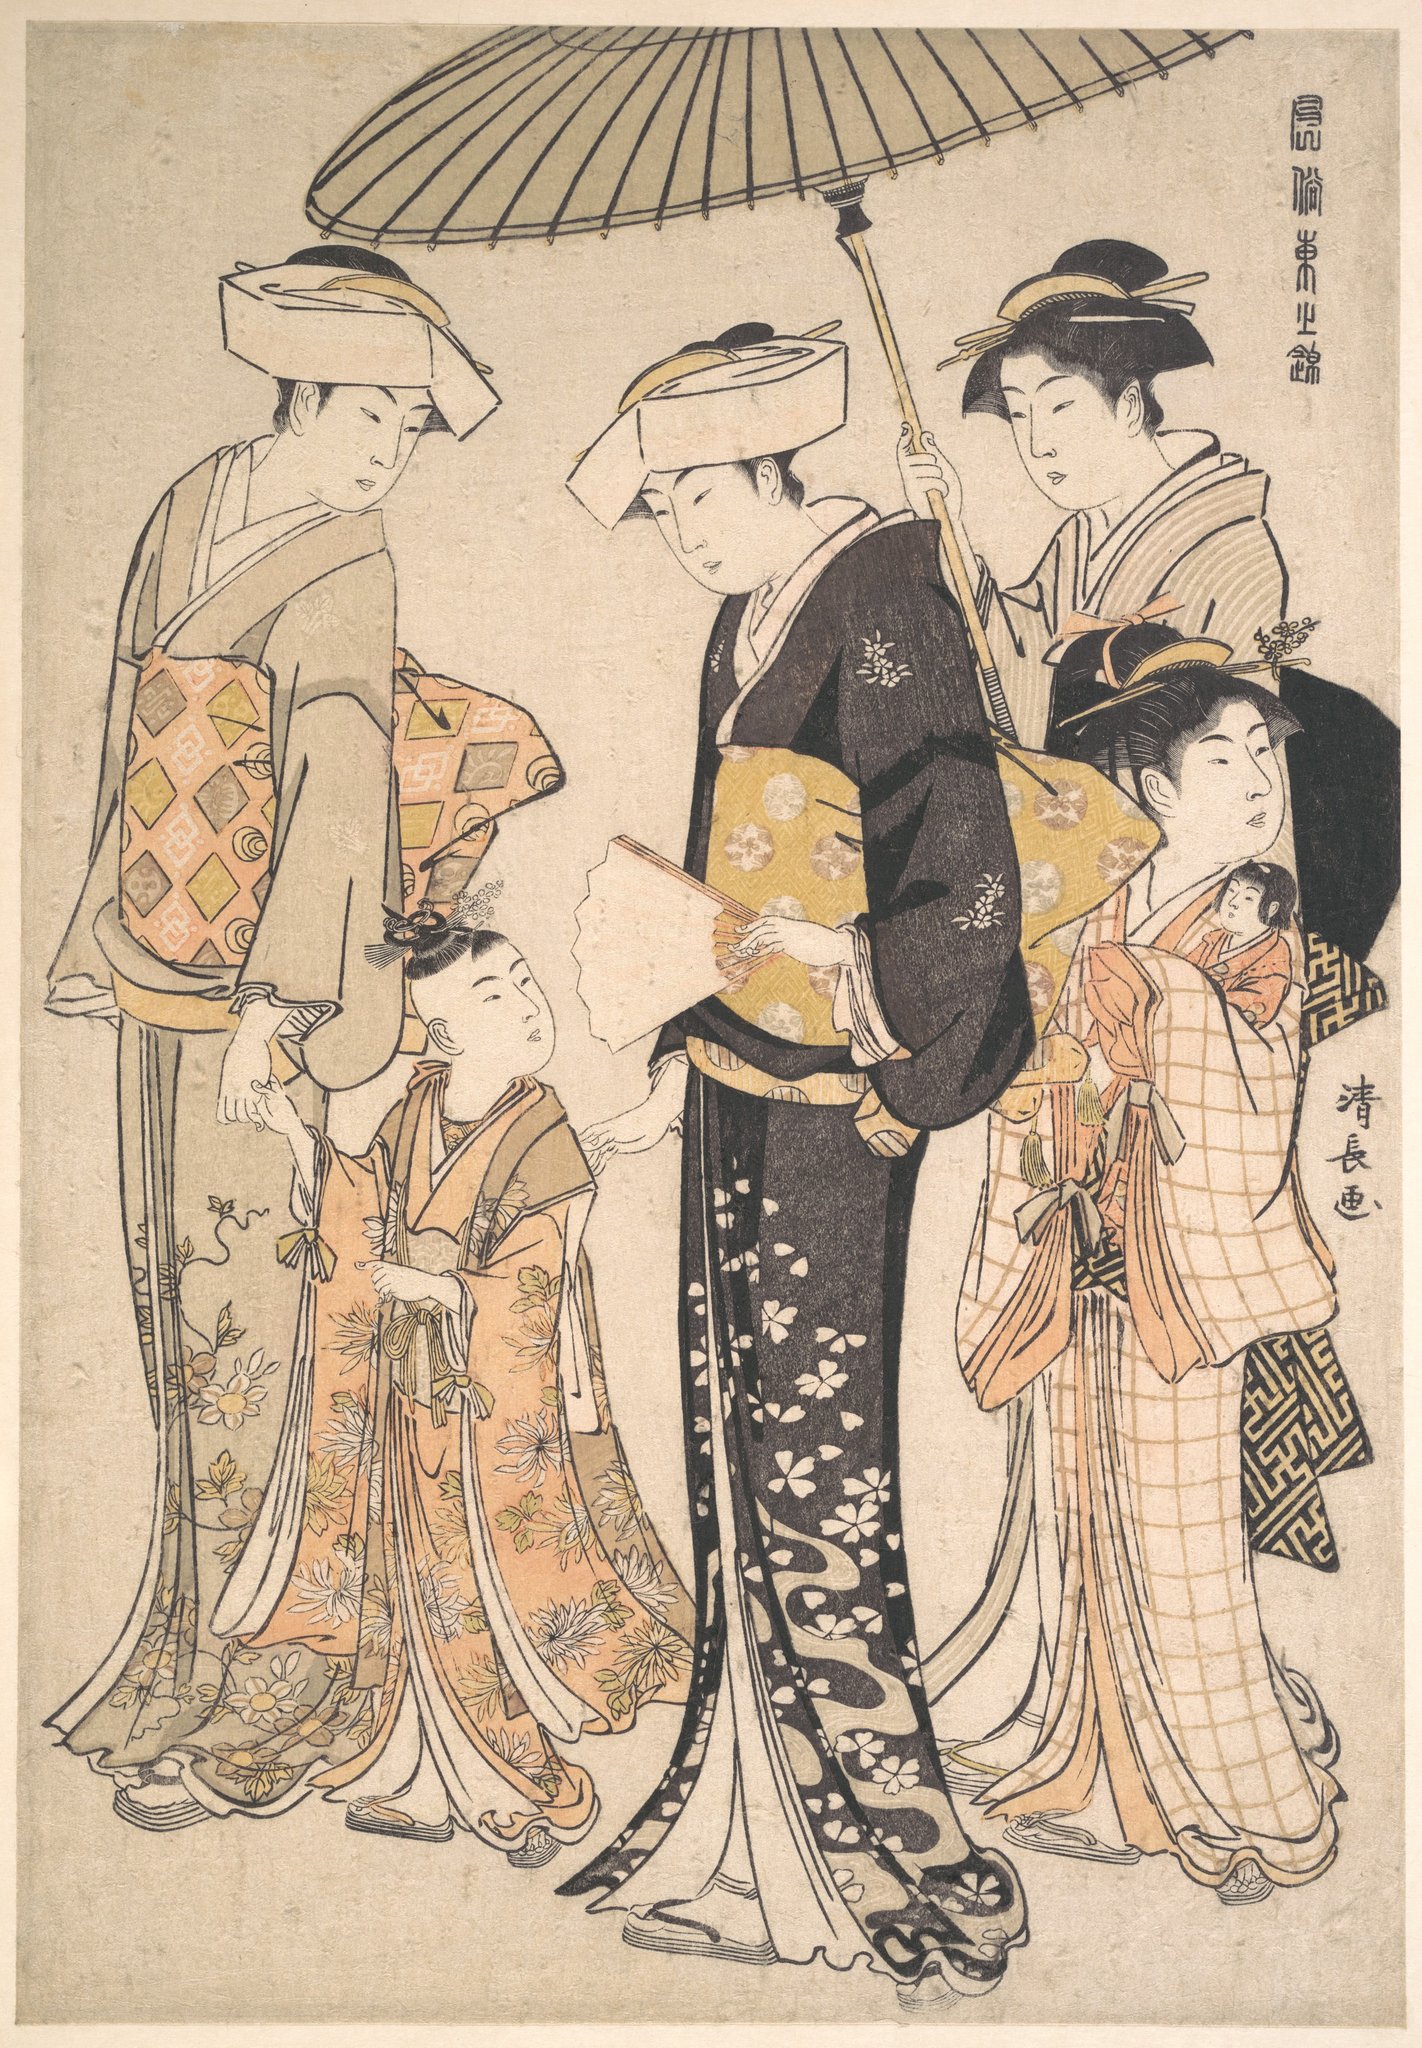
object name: print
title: High-Ranking Samurai Girl with Four Attendants, from the series A Brocade of Eastern Manners (Fūzoku Azuma no nishiki)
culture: japanese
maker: torii kiyonaga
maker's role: artist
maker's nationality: japanese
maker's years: 1752-1815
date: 1784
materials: ink, paper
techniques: woodblock print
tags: fans,girls,women